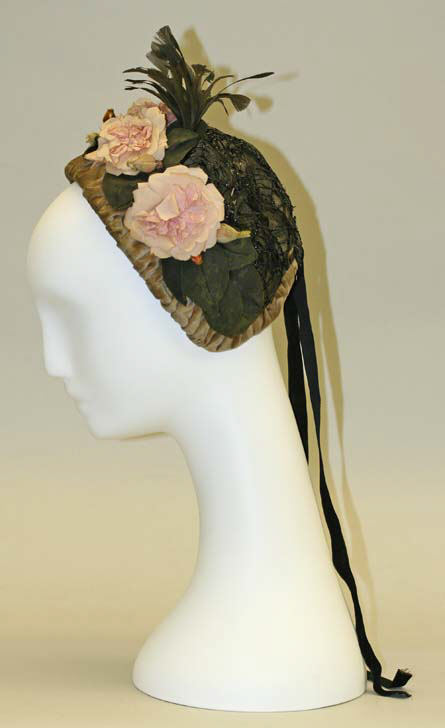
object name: bonnet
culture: american or european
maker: r.h. stearns company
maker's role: department store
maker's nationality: american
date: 1880-1889